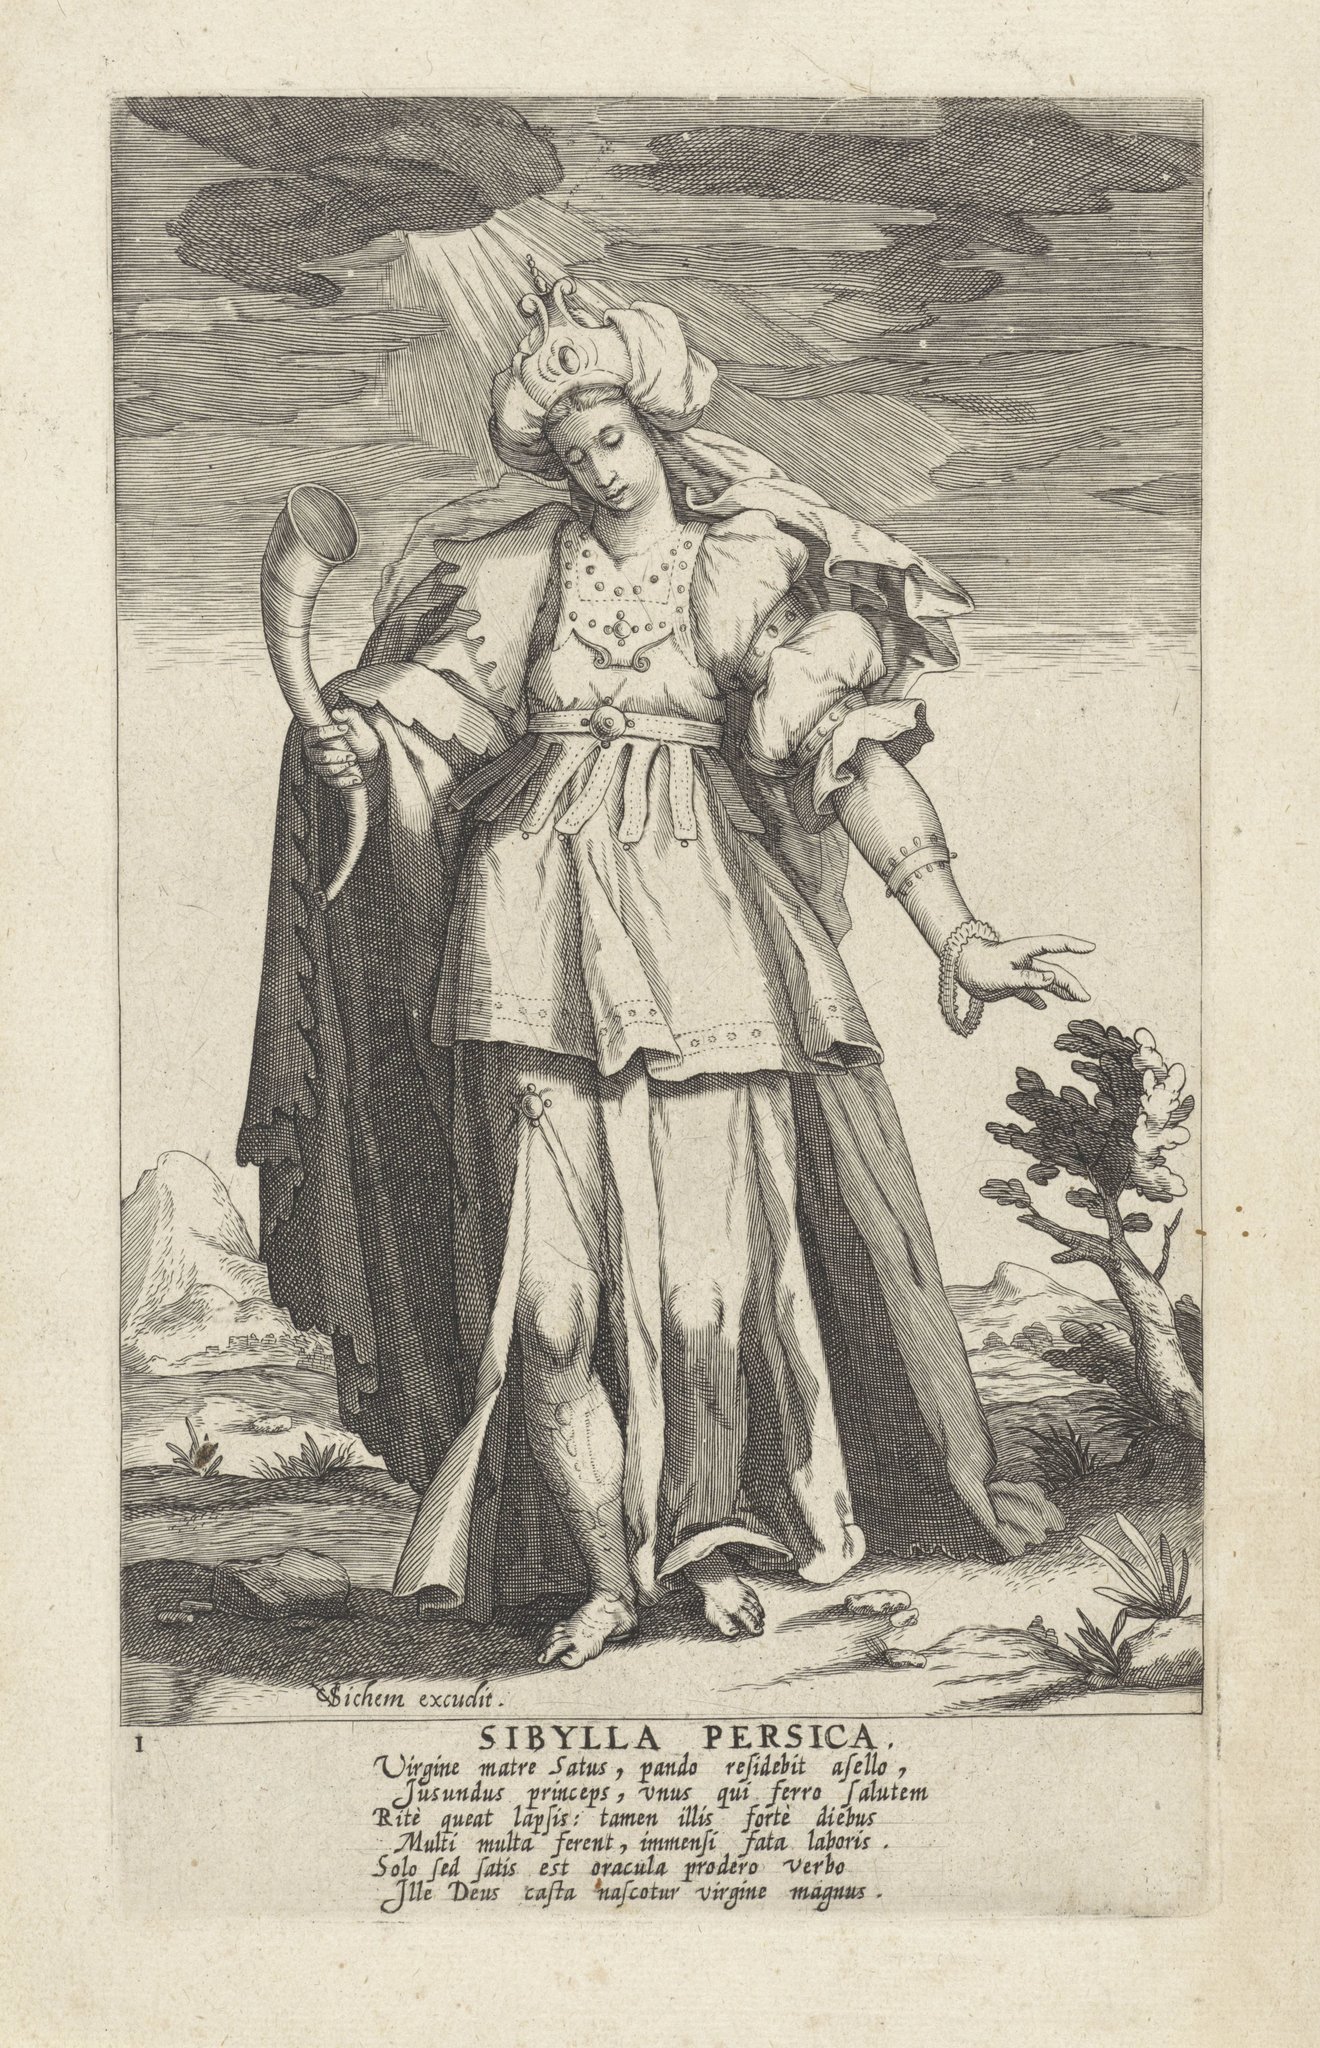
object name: print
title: Twaalf Sibillen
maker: christoffel van sichem (i)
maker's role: print maker, publisher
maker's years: 1546-1624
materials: paper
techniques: engraving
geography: amsterdam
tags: persian sibyl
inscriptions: collector's mark: Lugt 2228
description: Prent tevens gebruikt in: (Onuphrius Panvinius). Beschryvinghe ende heerelĳcke afbeeldinghe der twaelf Sibyllen. Vertaald uit het Latijn door R. Lubbaeus. Amsterdam: C. van Sichem, 1608.